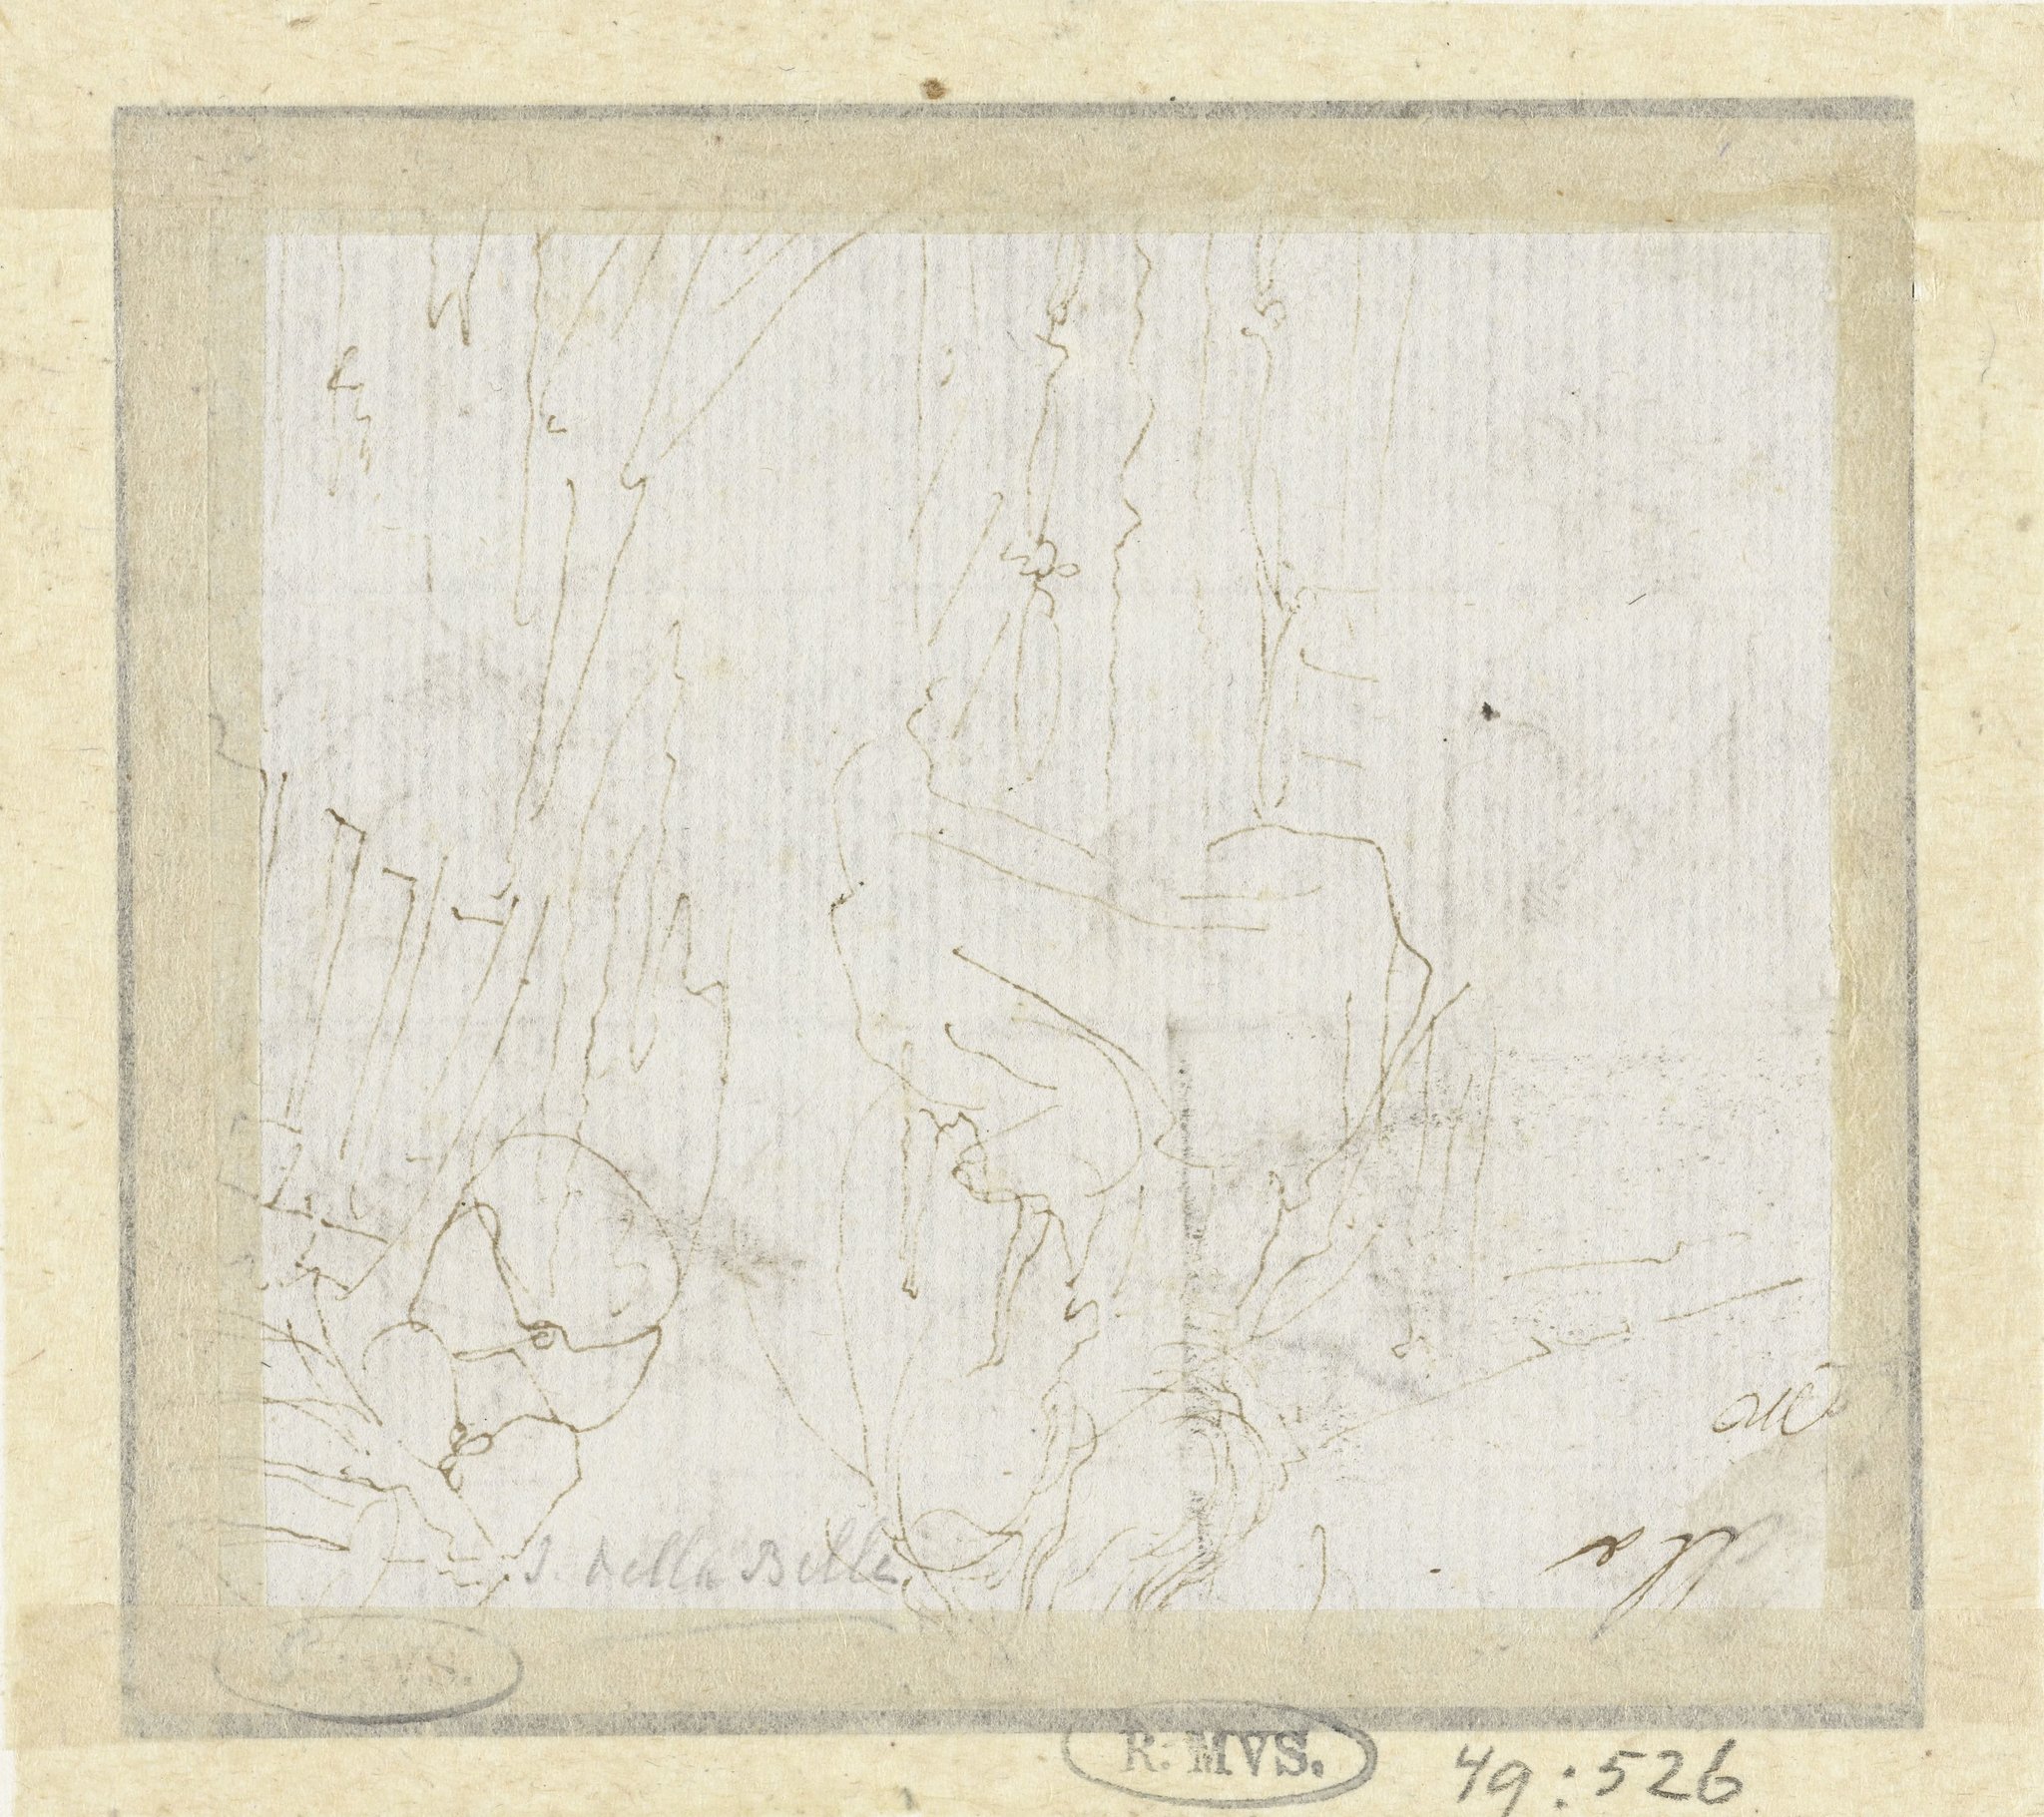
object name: drawing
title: Schetsblad met twee staande figuren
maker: stefano della bella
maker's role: draughtsman, print maker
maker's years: 1610-1664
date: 1620-1664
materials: ink, paper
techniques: pen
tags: standing figure